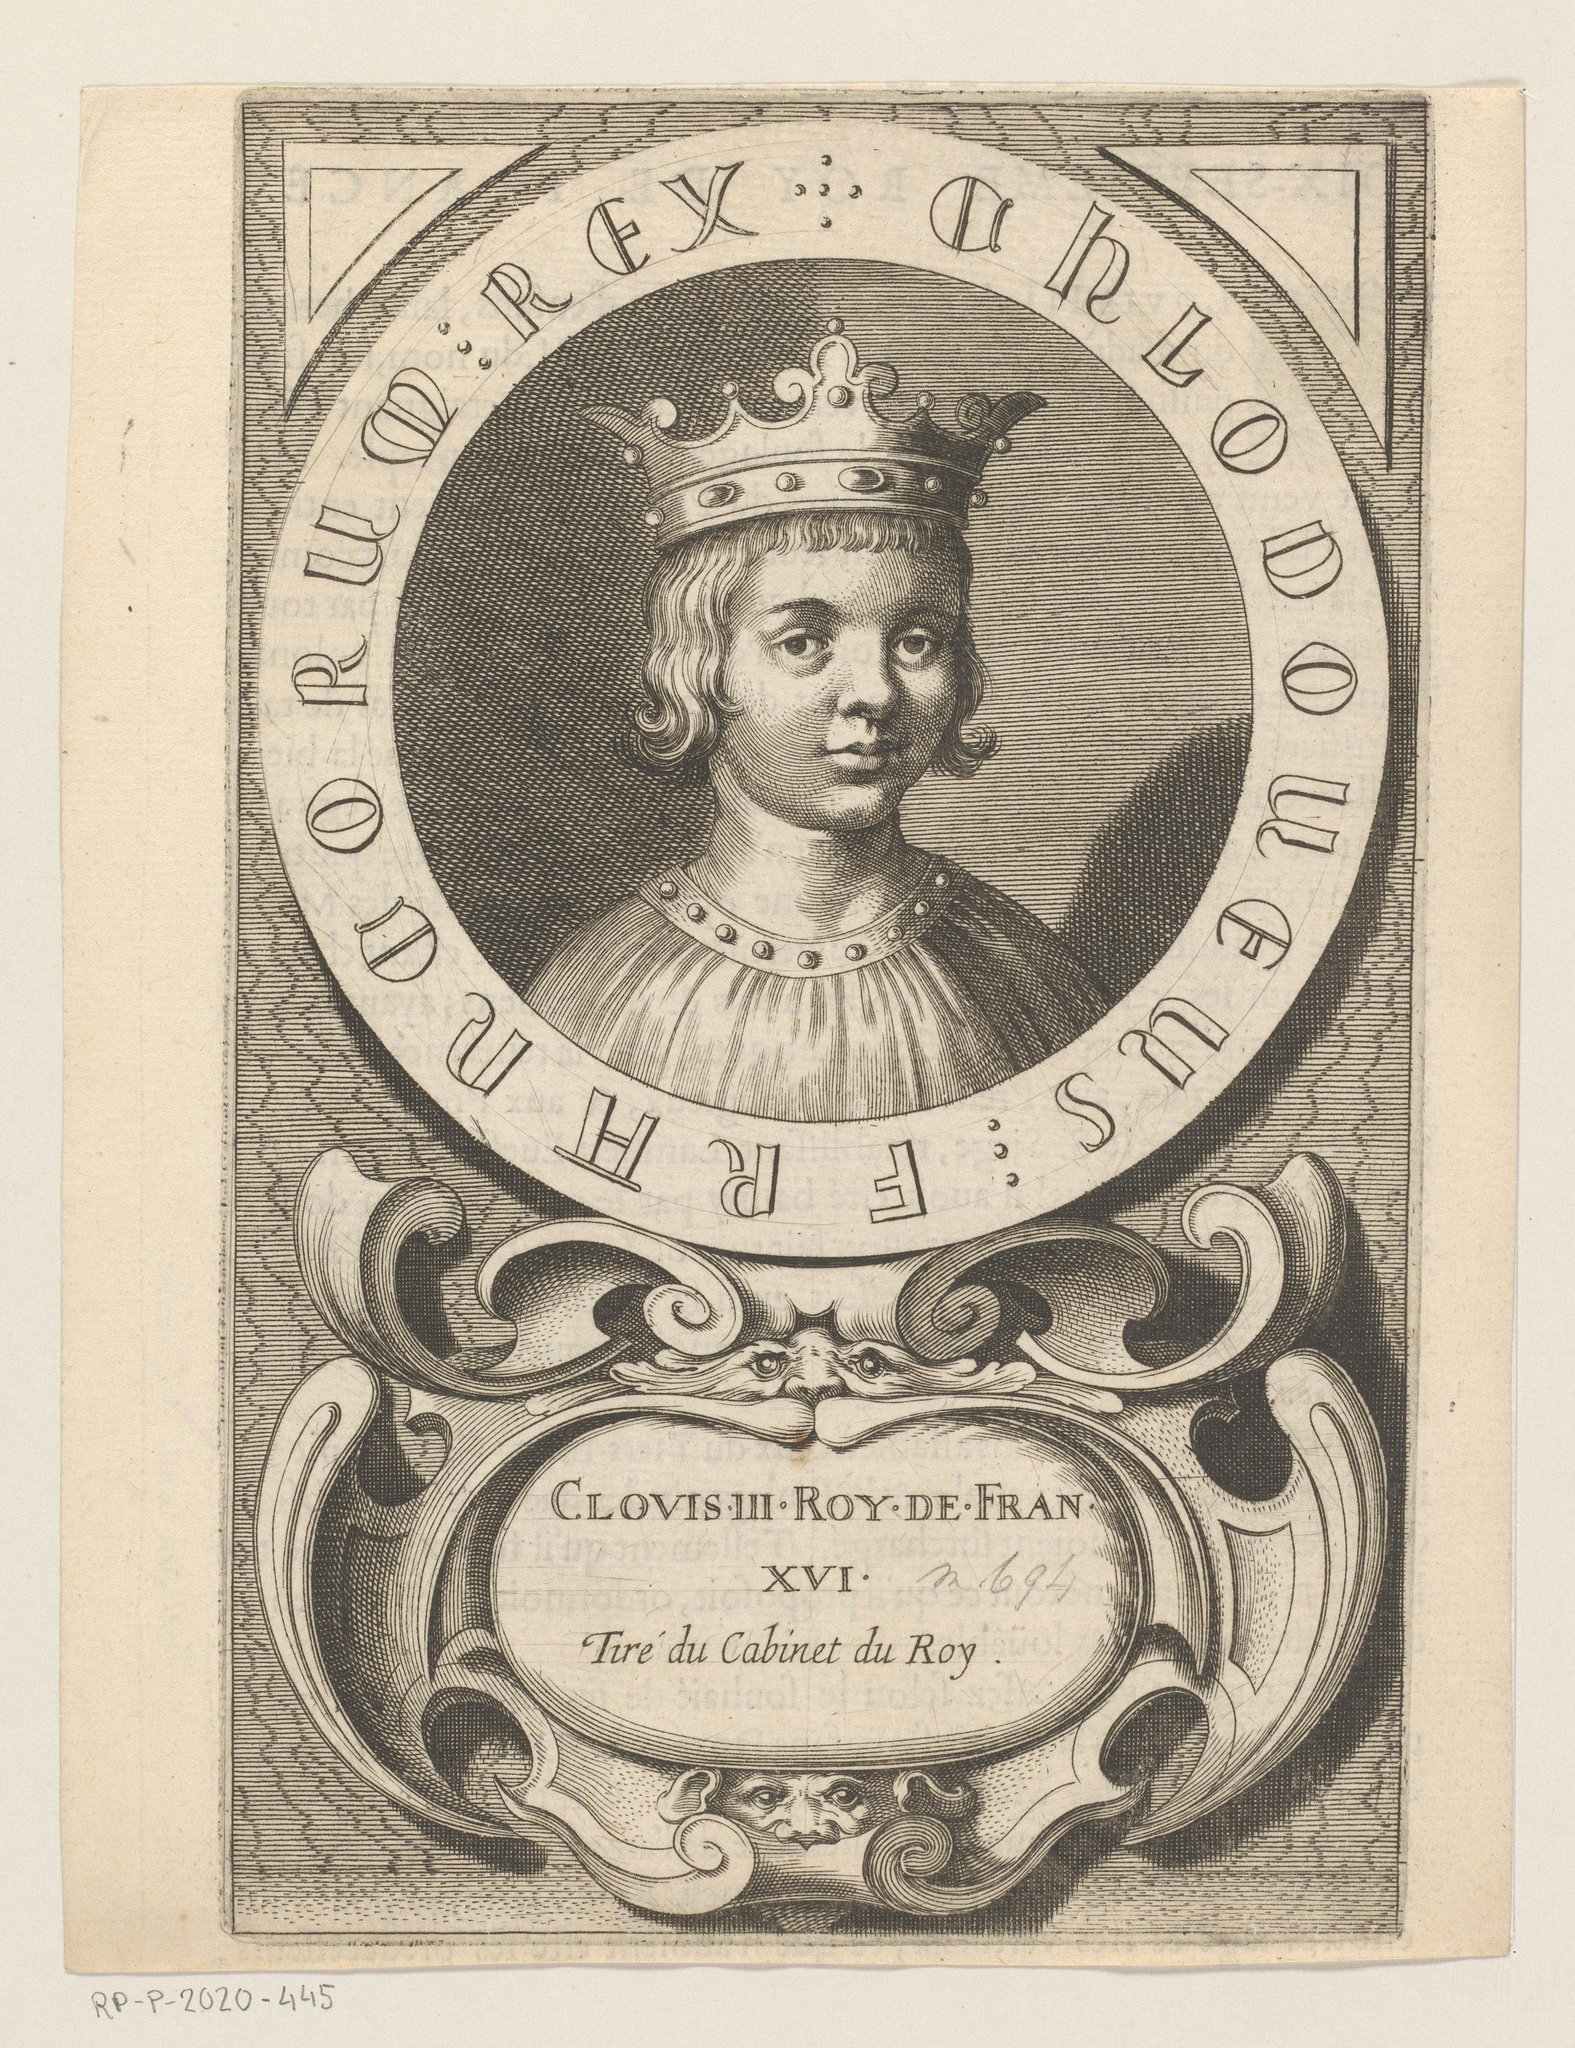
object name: print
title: Portret van Clovis IV, koning van Neustrië, Bourgondië en Austrasië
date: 1636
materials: paper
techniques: engraving, letterpress printing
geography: paris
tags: historical persons, ruler, sovereign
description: Prent uit: Bie, Jacques de. Les vrais portraits des rois de France (...). Parijs: Jean Camusat, 1636. Prent ook gebruikt in latere publicaties.